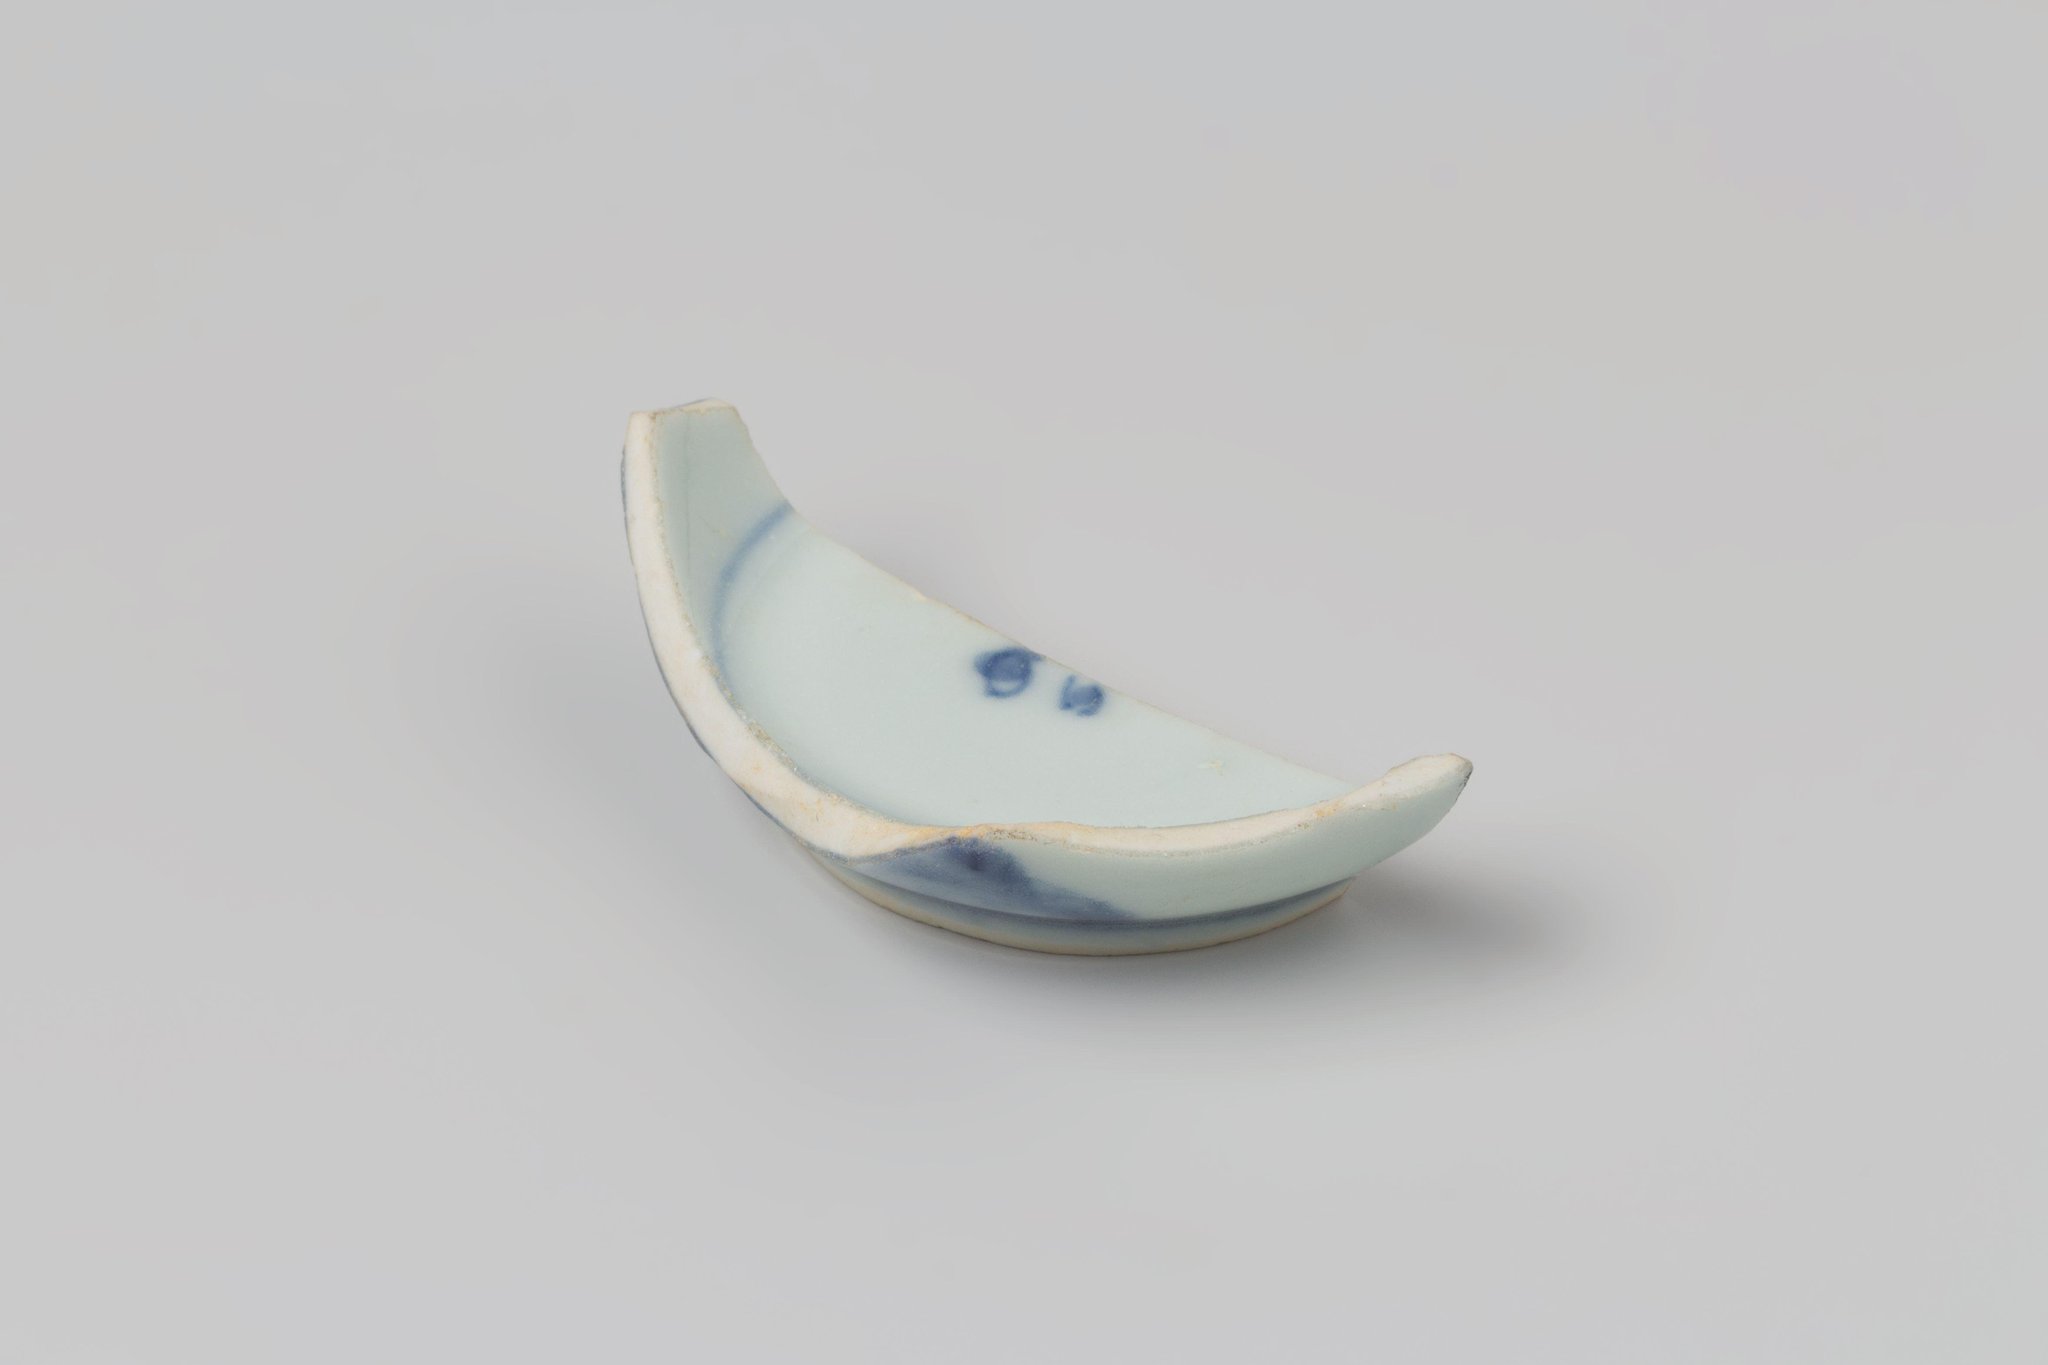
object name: cup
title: Scherf van een kop uit het wrak van de Oost-Indiëvaarder Hollandia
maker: Anonymous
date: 1700-1743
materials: porcelain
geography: netherlands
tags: verenigde oostindische compagnie, hollandia (schip), annet